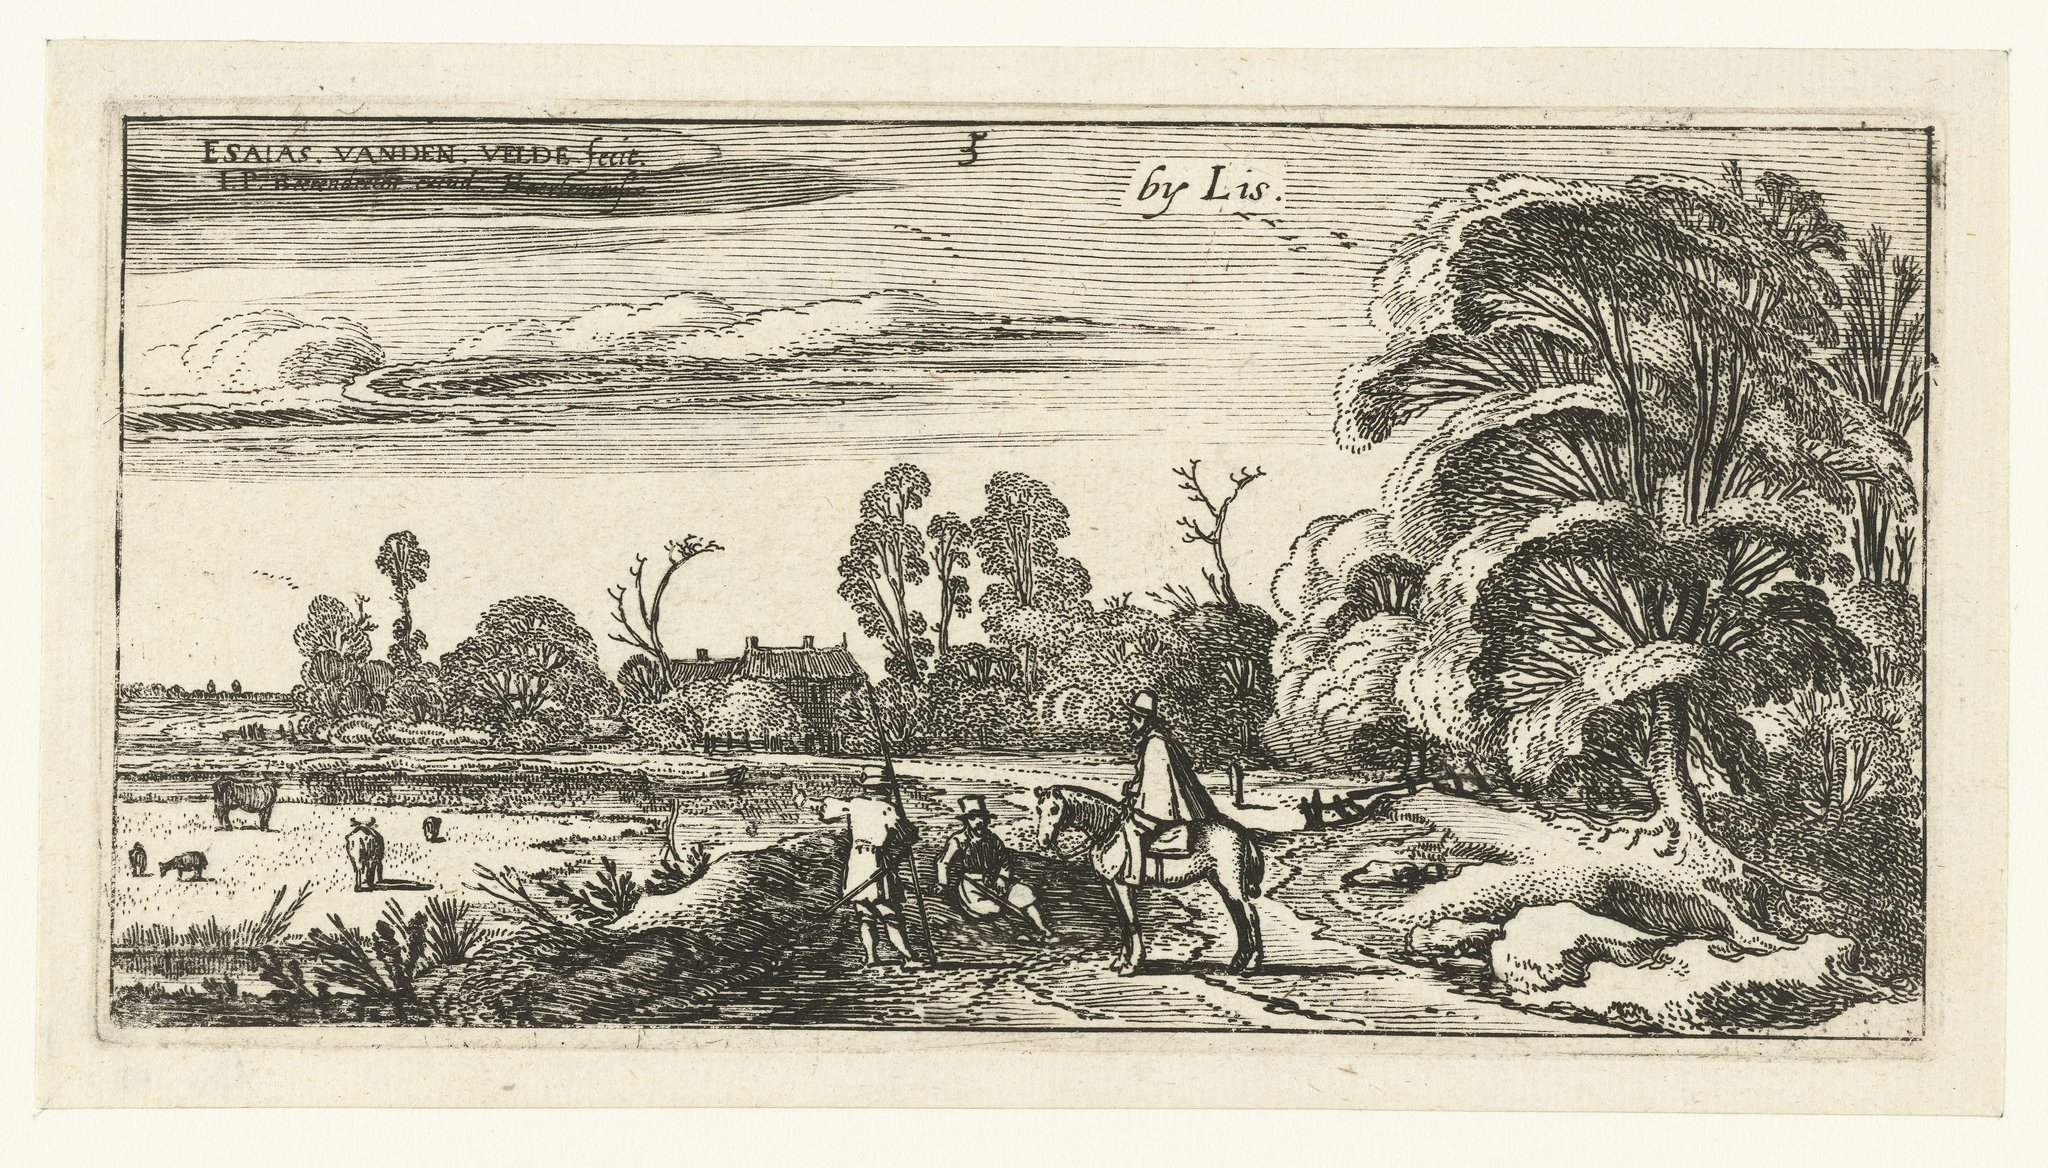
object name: print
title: Landschappen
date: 1615-1616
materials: paper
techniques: engraving, etching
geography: haarlem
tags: prospect of village, silhouette of village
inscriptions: collector's mark: Lugt 2228a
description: Het landschap in de omgeving van Lisse heeft in deze staat naast wijzigingen in de wolkenlucht ook een opschrift gekregen: by Lis. De naam van de vorige uitgever Berendrecht is met horizontale lijnen weggewerkt.